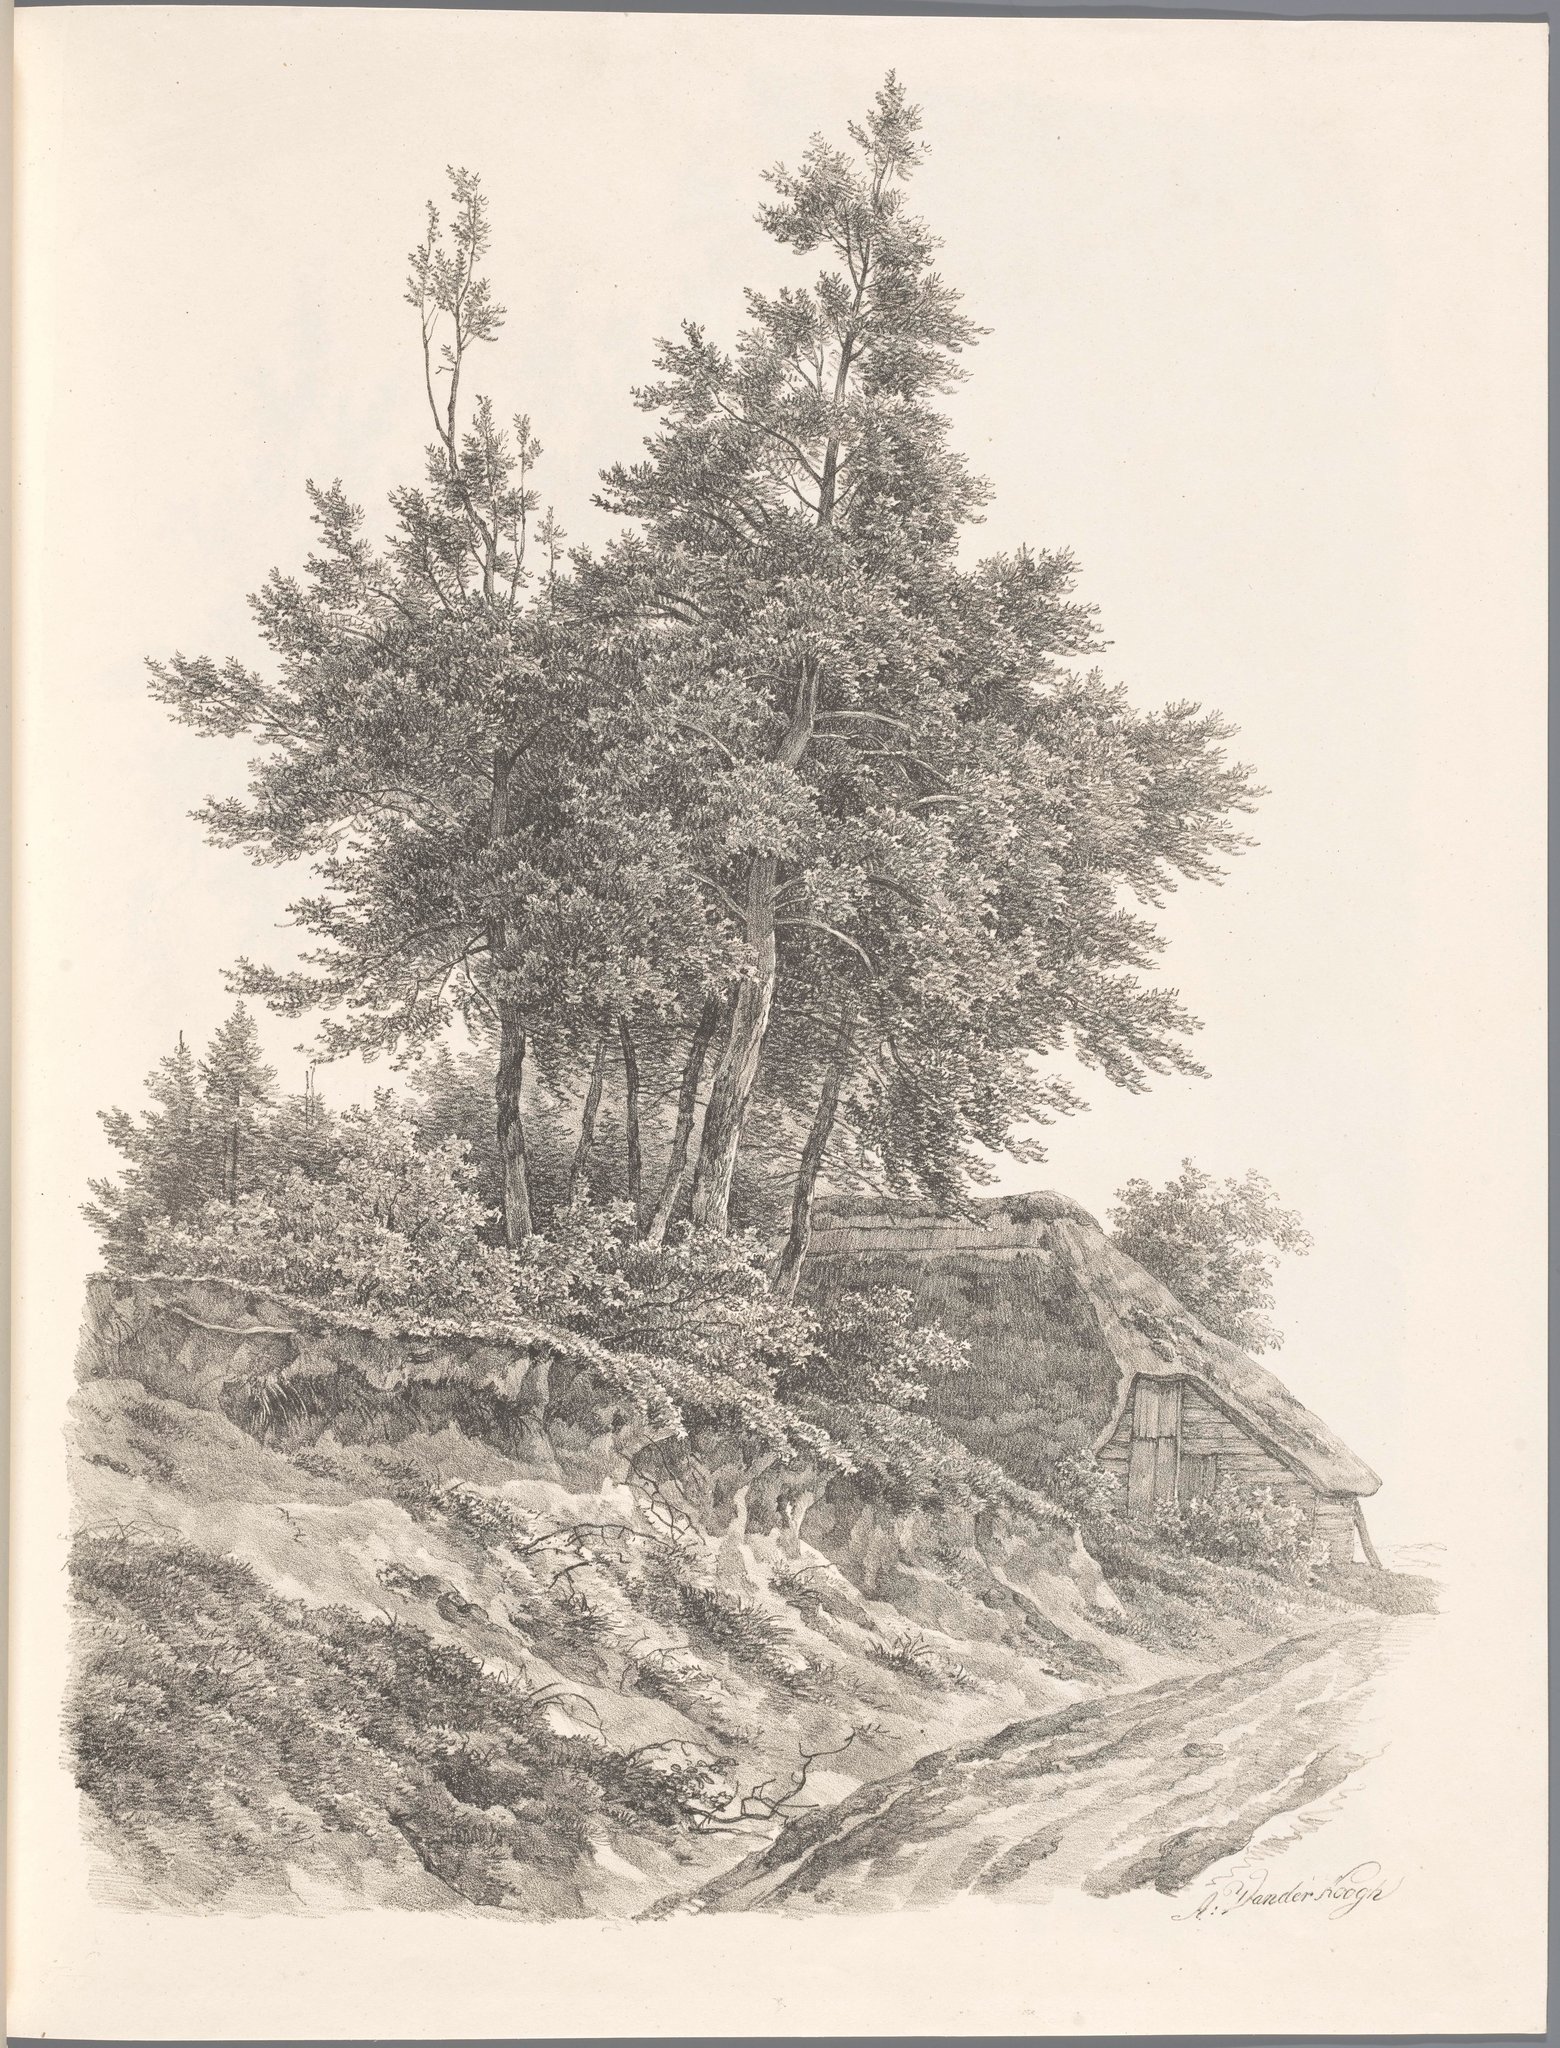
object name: print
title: Boomstudiën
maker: adrianus van der koogh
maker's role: draughtsman, print maker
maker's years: 1796-1831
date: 1826-1828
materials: paper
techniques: lithograph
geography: dordrecht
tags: road, path, groups of trees, farm (building)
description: In 1826 gaf Steuerwald & Comp een serie boomstudies uit van Adrianus van der Koogh, bedoeld voor het tekenonderwijs. In de collectie van het Rijksmuseum bevinden zich de omslag voor deze eerste bundel uit 1826 (RP-P-OB-28.980) en de titelprent voor een tweede bundel uit 1828 (RP-P-OB-68.274). In de literatuur wordt enkel de uitgave in 1826 genoemd. Zie: Kramm, 1859.